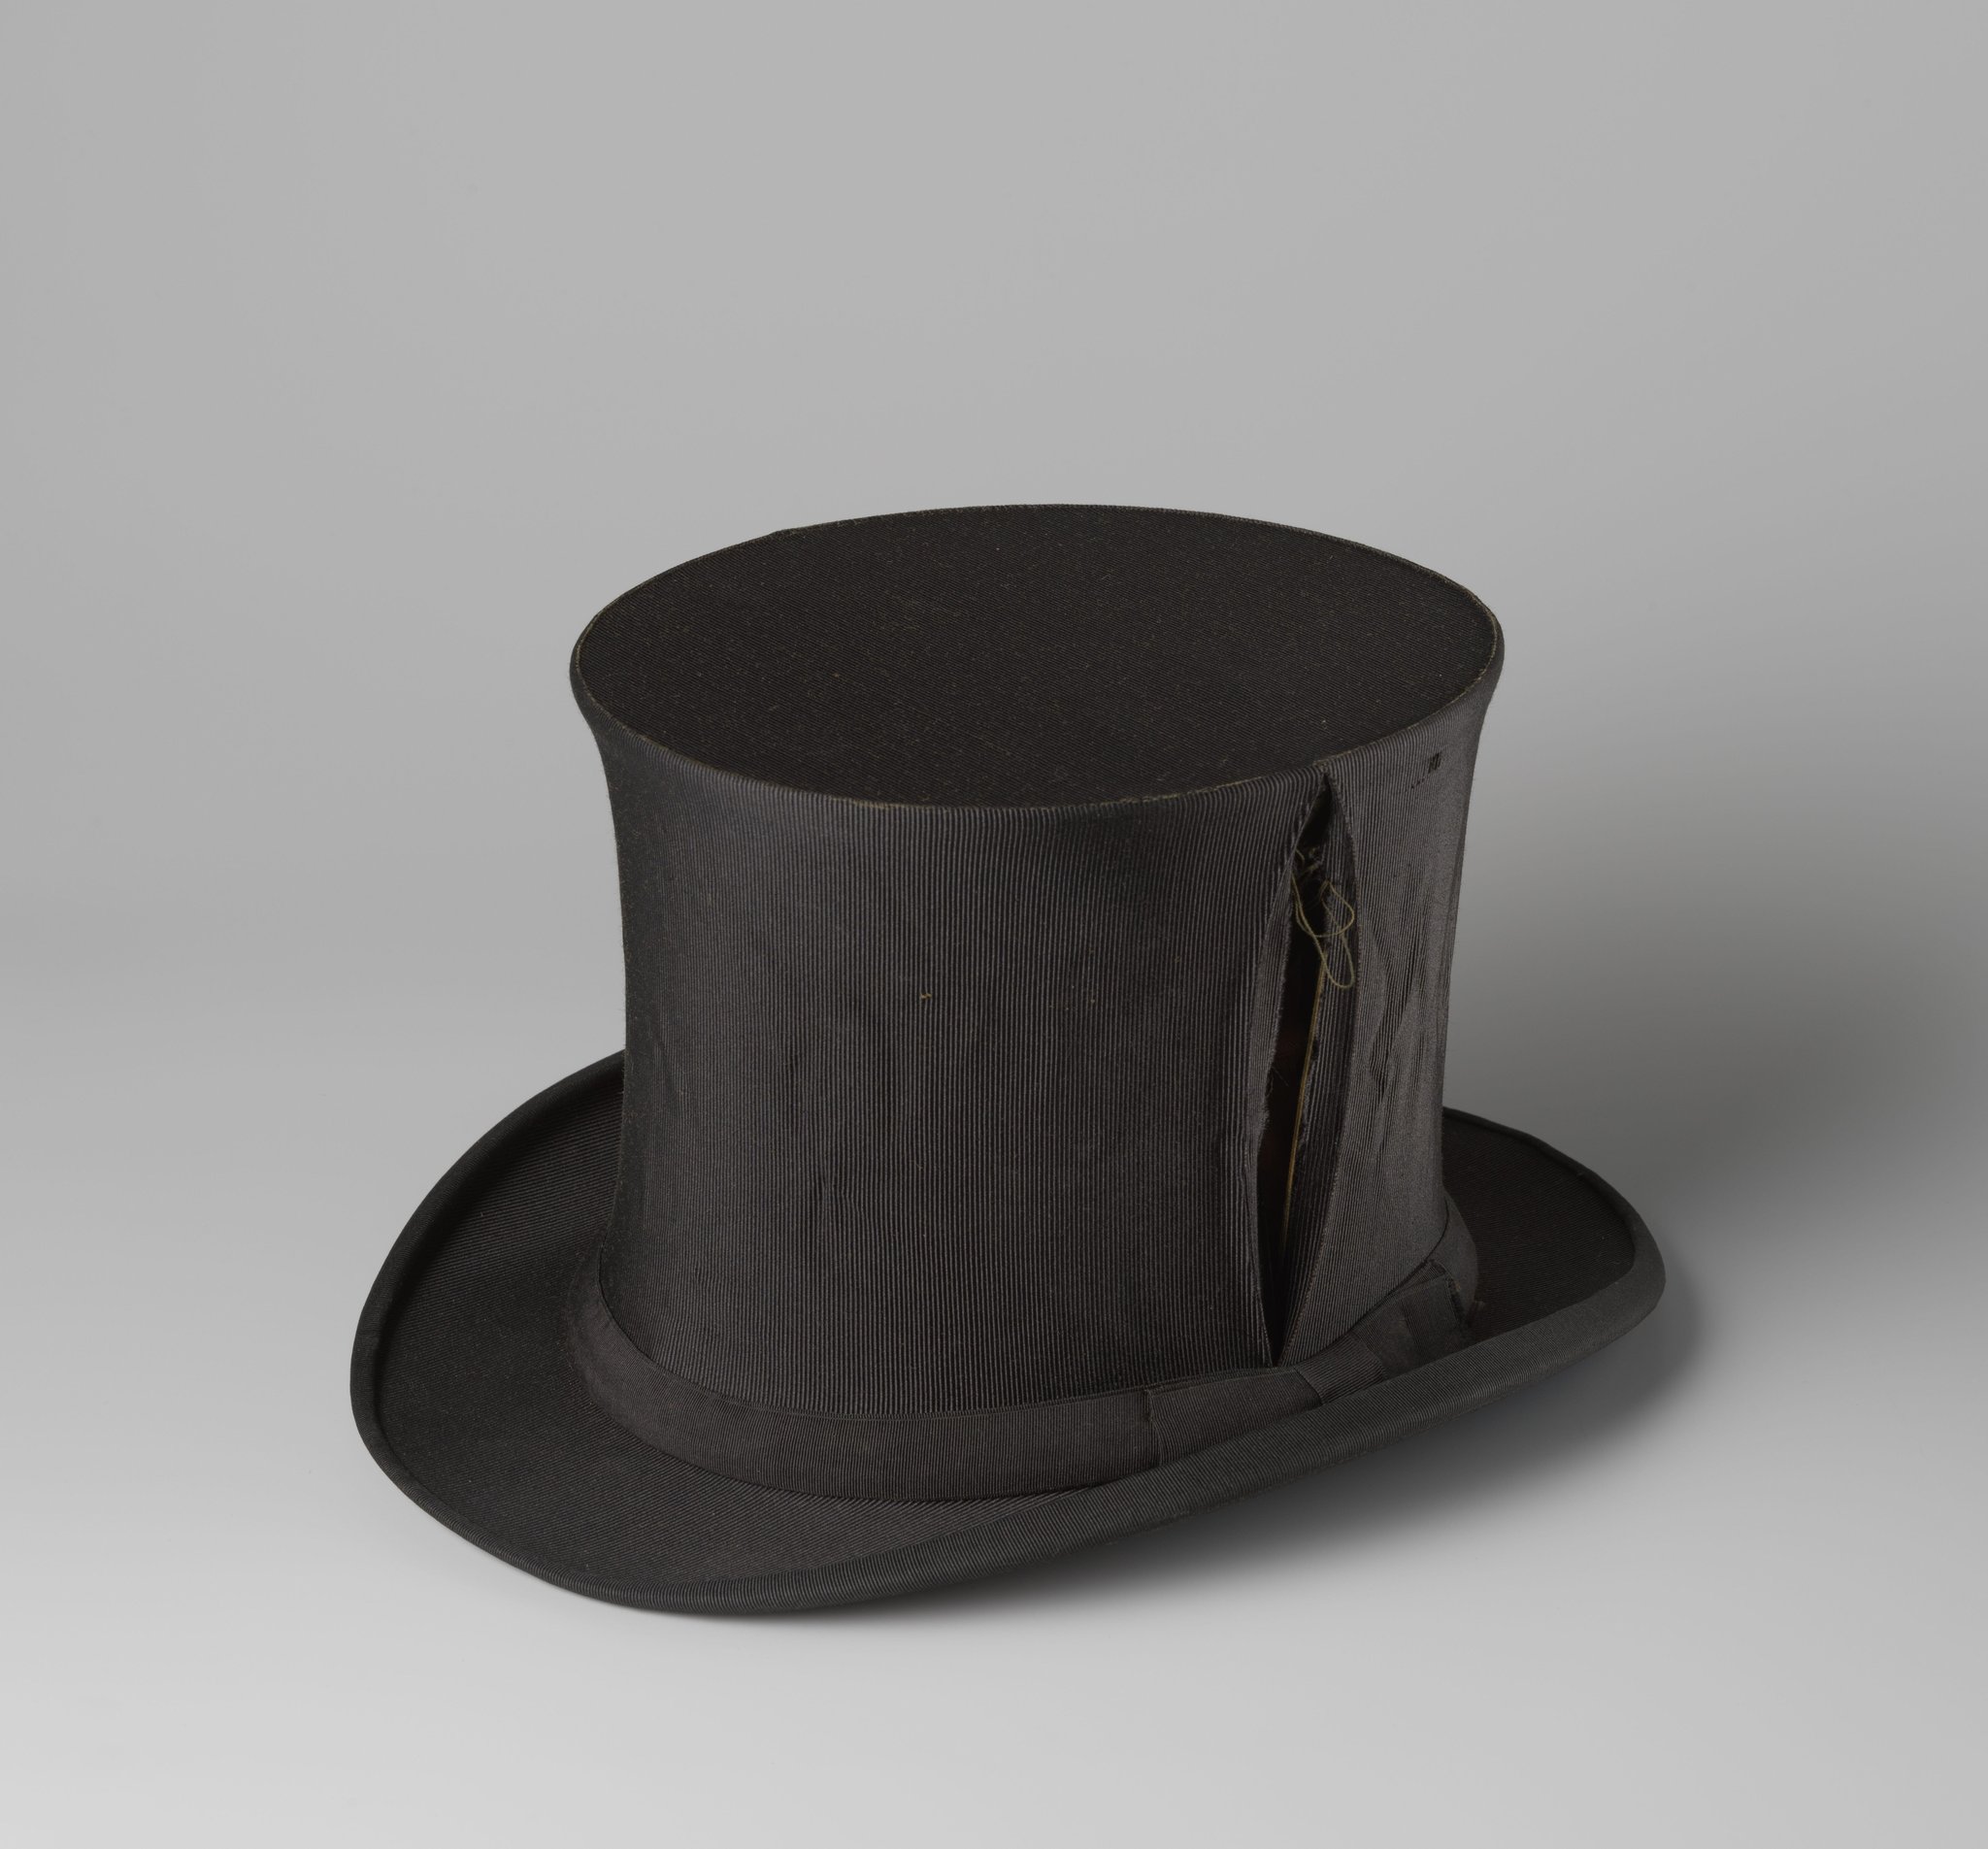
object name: top hat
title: Hoge hoed van dofzwarte ripszijde met veermechaniek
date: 1910-1925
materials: paper, silk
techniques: rib binding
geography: paris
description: Hoge hoed, chapeau claque, van dofzwarte ripszijde. Cilinderbol is van boven iets uitbuigend. De rand is van voren en van achter vlak, maar opzij duidelijk oplopend, met het lintrandje naar binnen teruggebogen. Veermechaniek. Smal hoedenlintje met een plat strikje. In een platte draagdoos met op het glimmend zwart papier het gouden firmastempel van de leverancier: gekroonde cirkel met een griffioen/ E L / BREVETE S.G. ? ? / PARIS, frans Pauwels, fournisseur de la Cour, La HAYE.